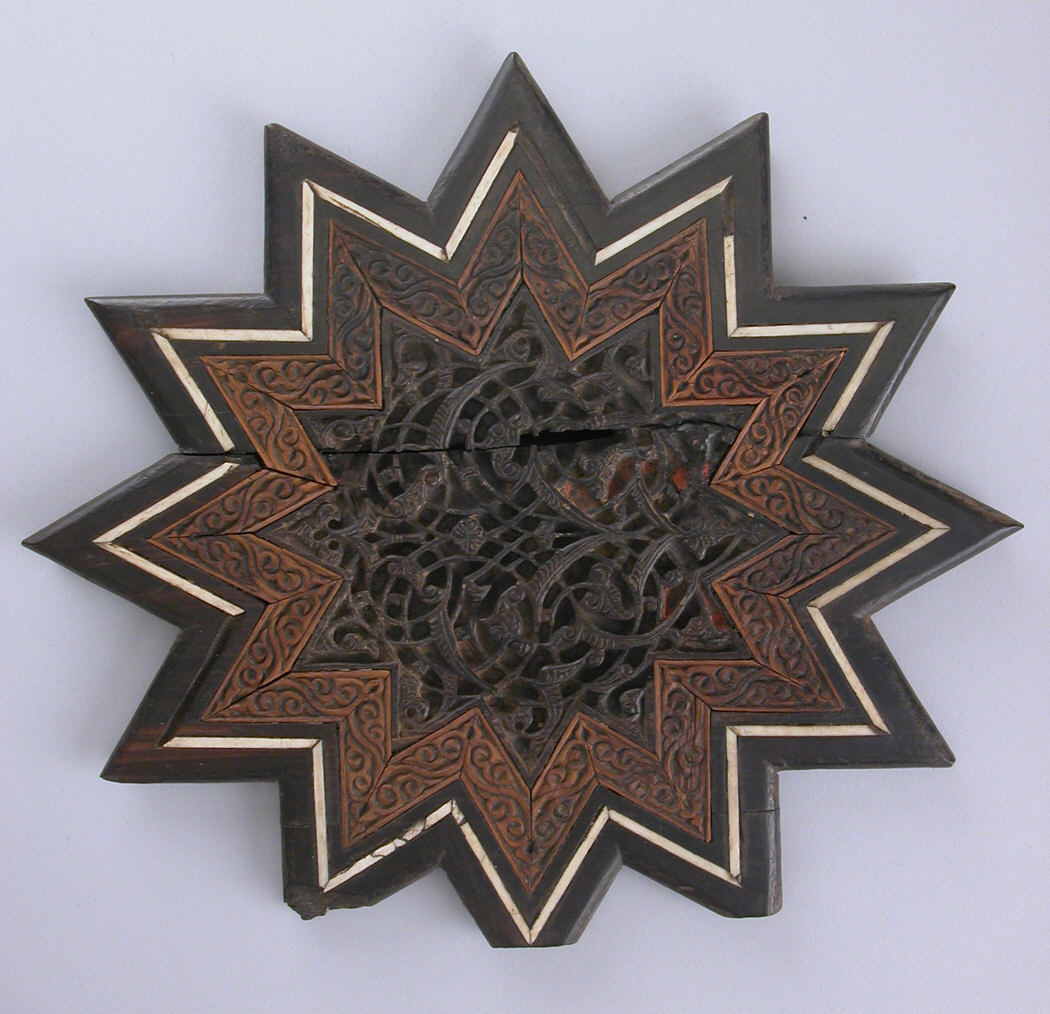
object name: panel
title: Panel from a Minbar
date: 1201-1400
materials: ivory, wood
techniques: carving, inlay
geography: egypt